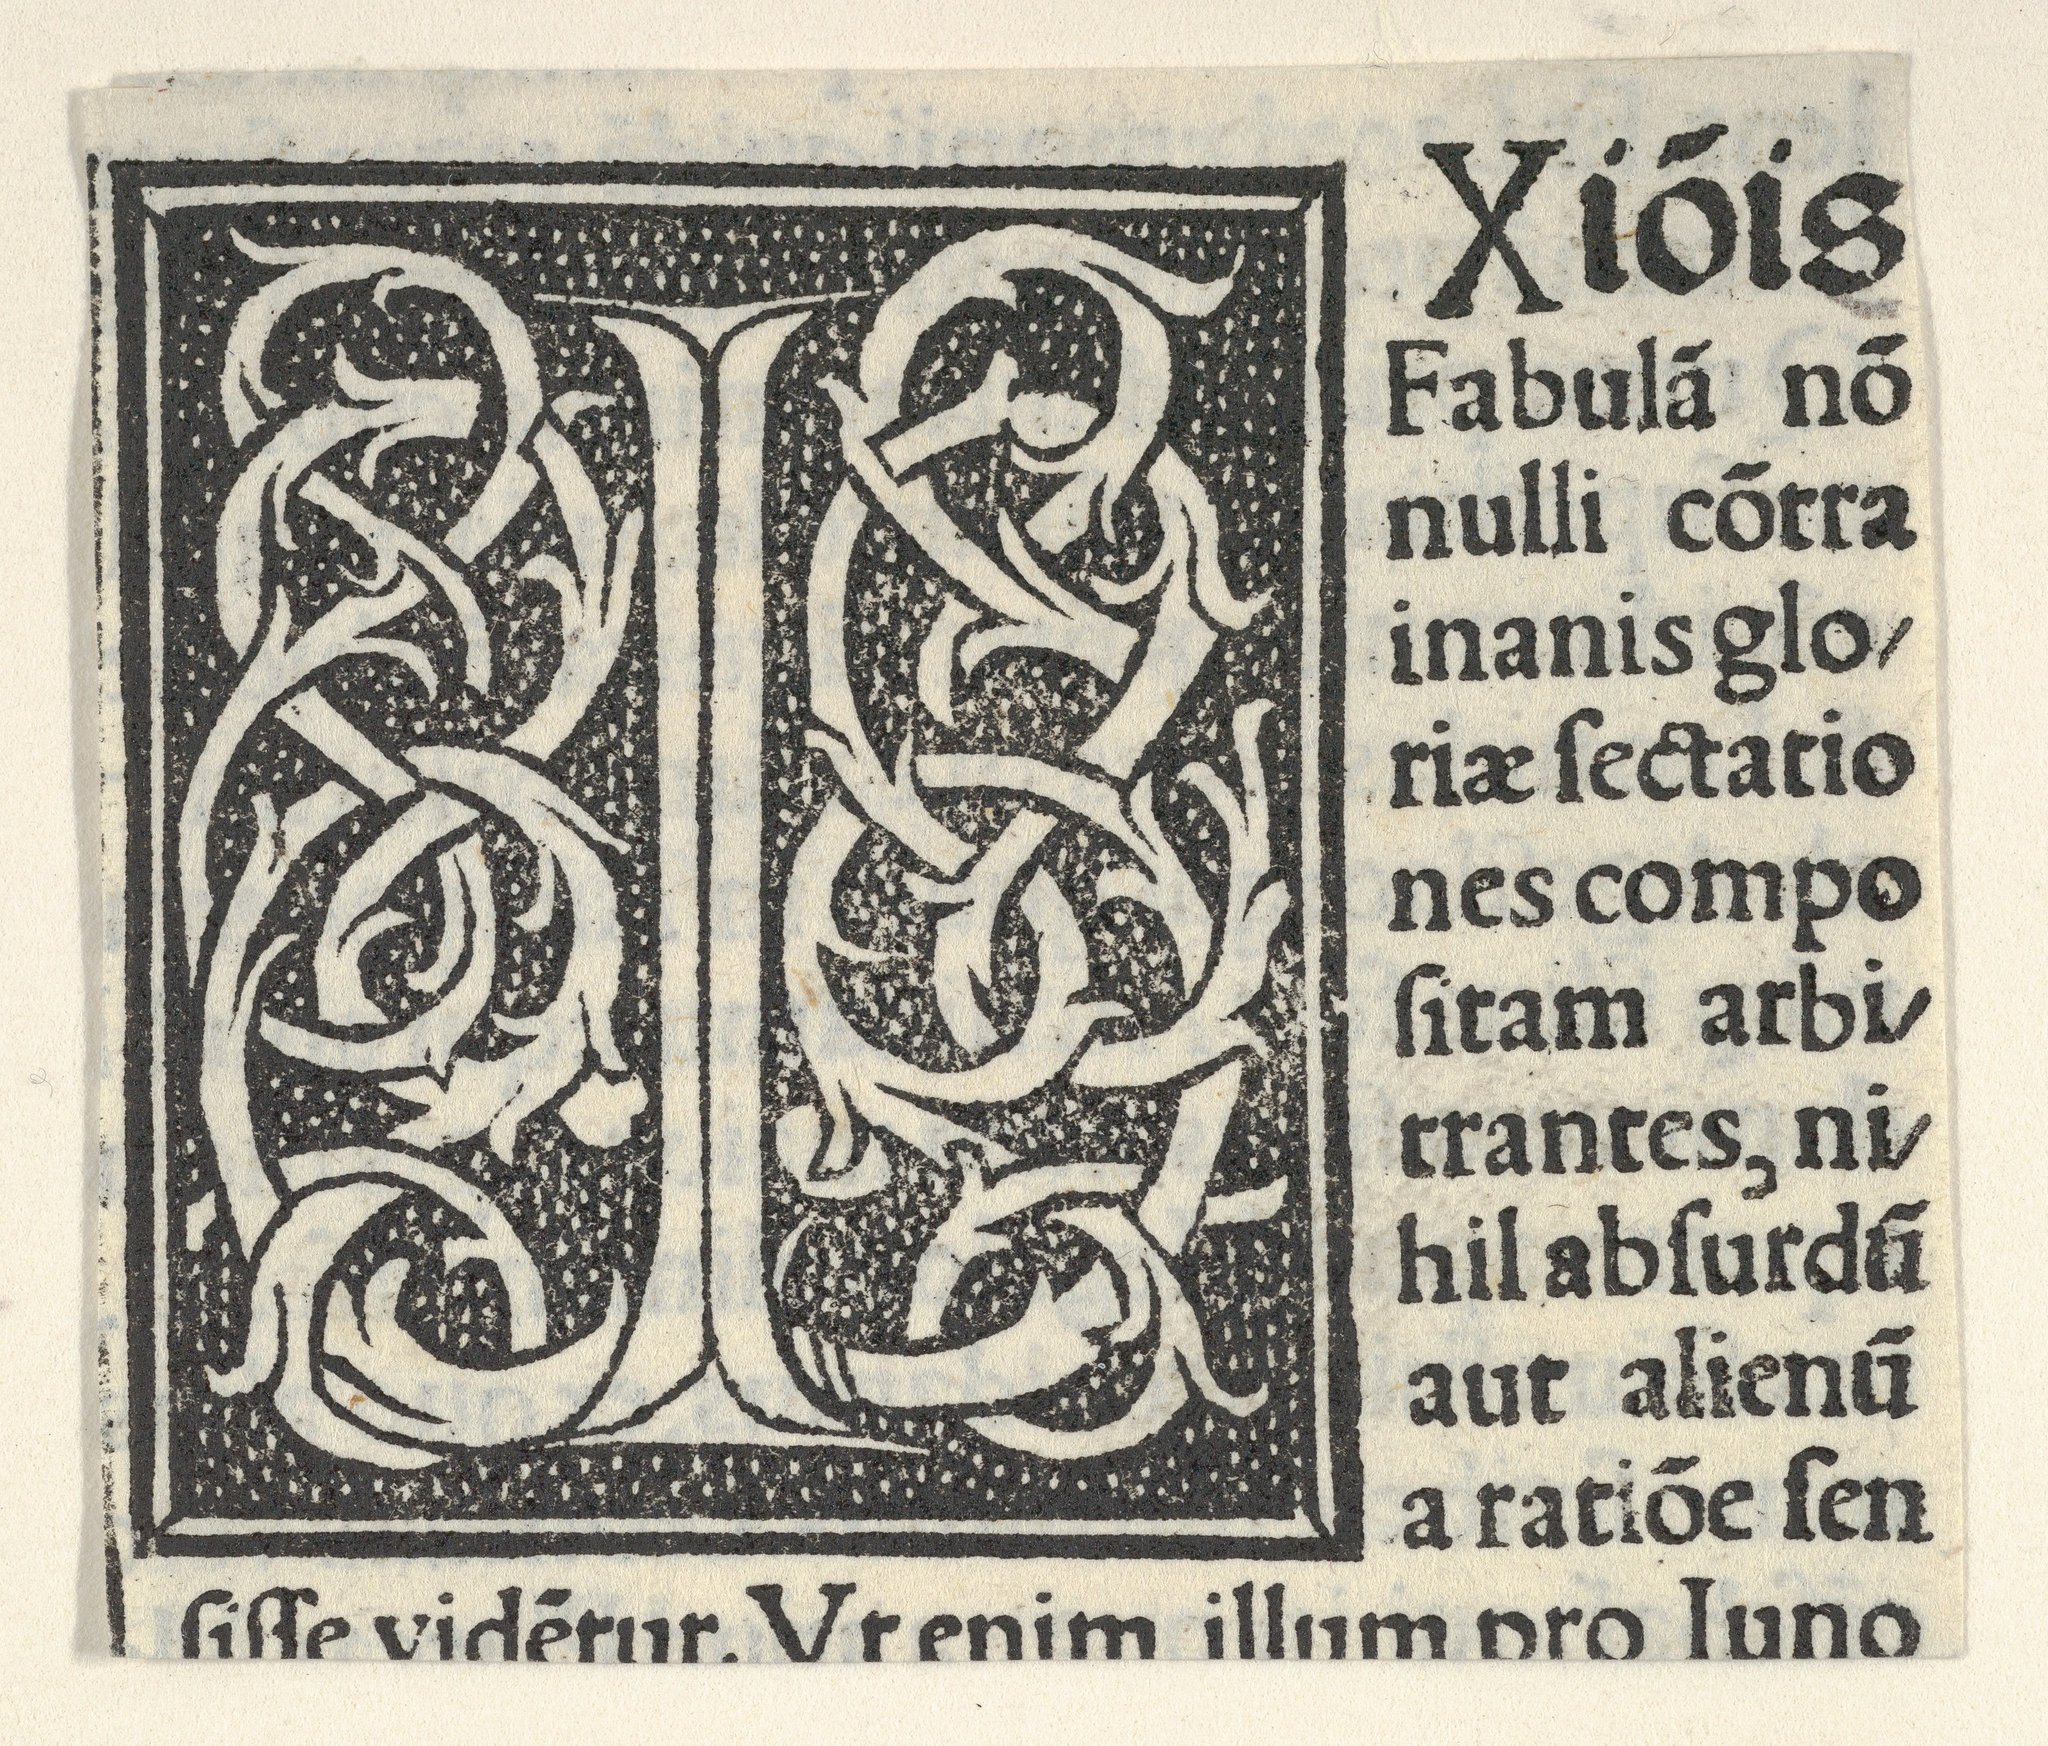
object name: print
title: Initial letter I on patterned background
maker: anonymous, italian, 16th century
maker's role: artist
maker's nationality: italian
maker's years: 1500-1600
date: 1520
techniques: woodcut